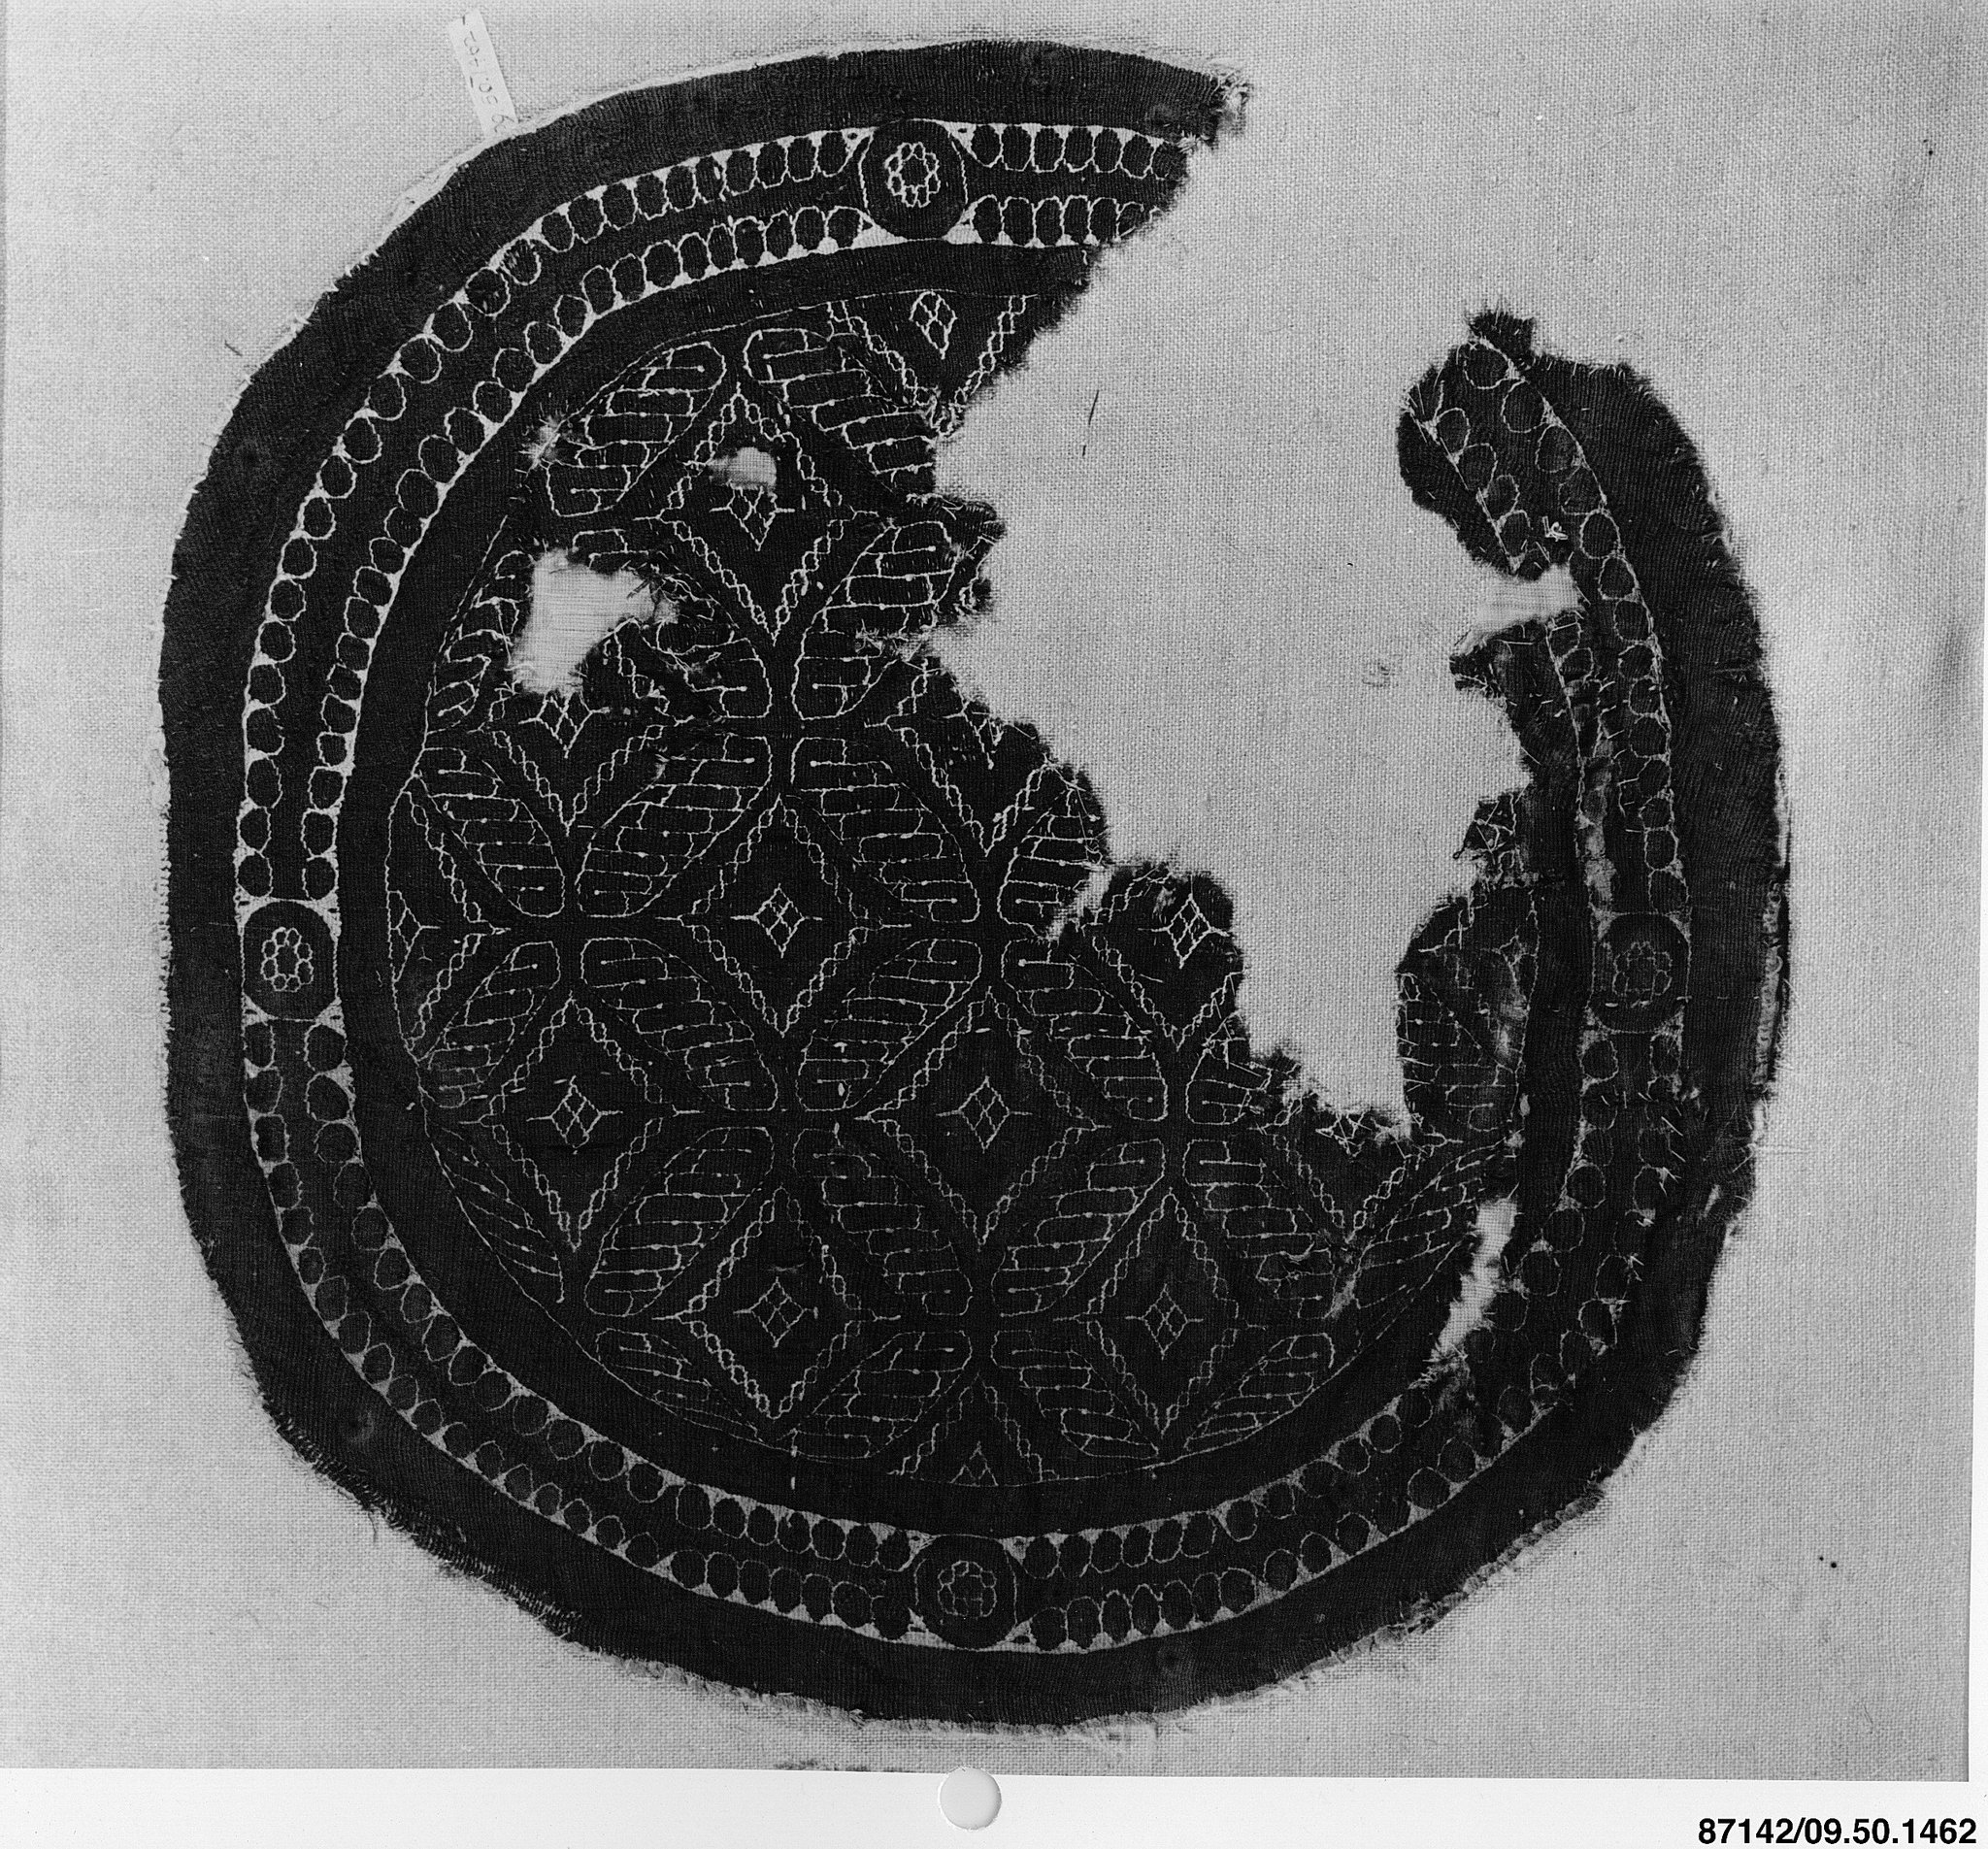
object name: roundel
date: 201-400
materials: linen, wool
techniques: weave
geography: egypt